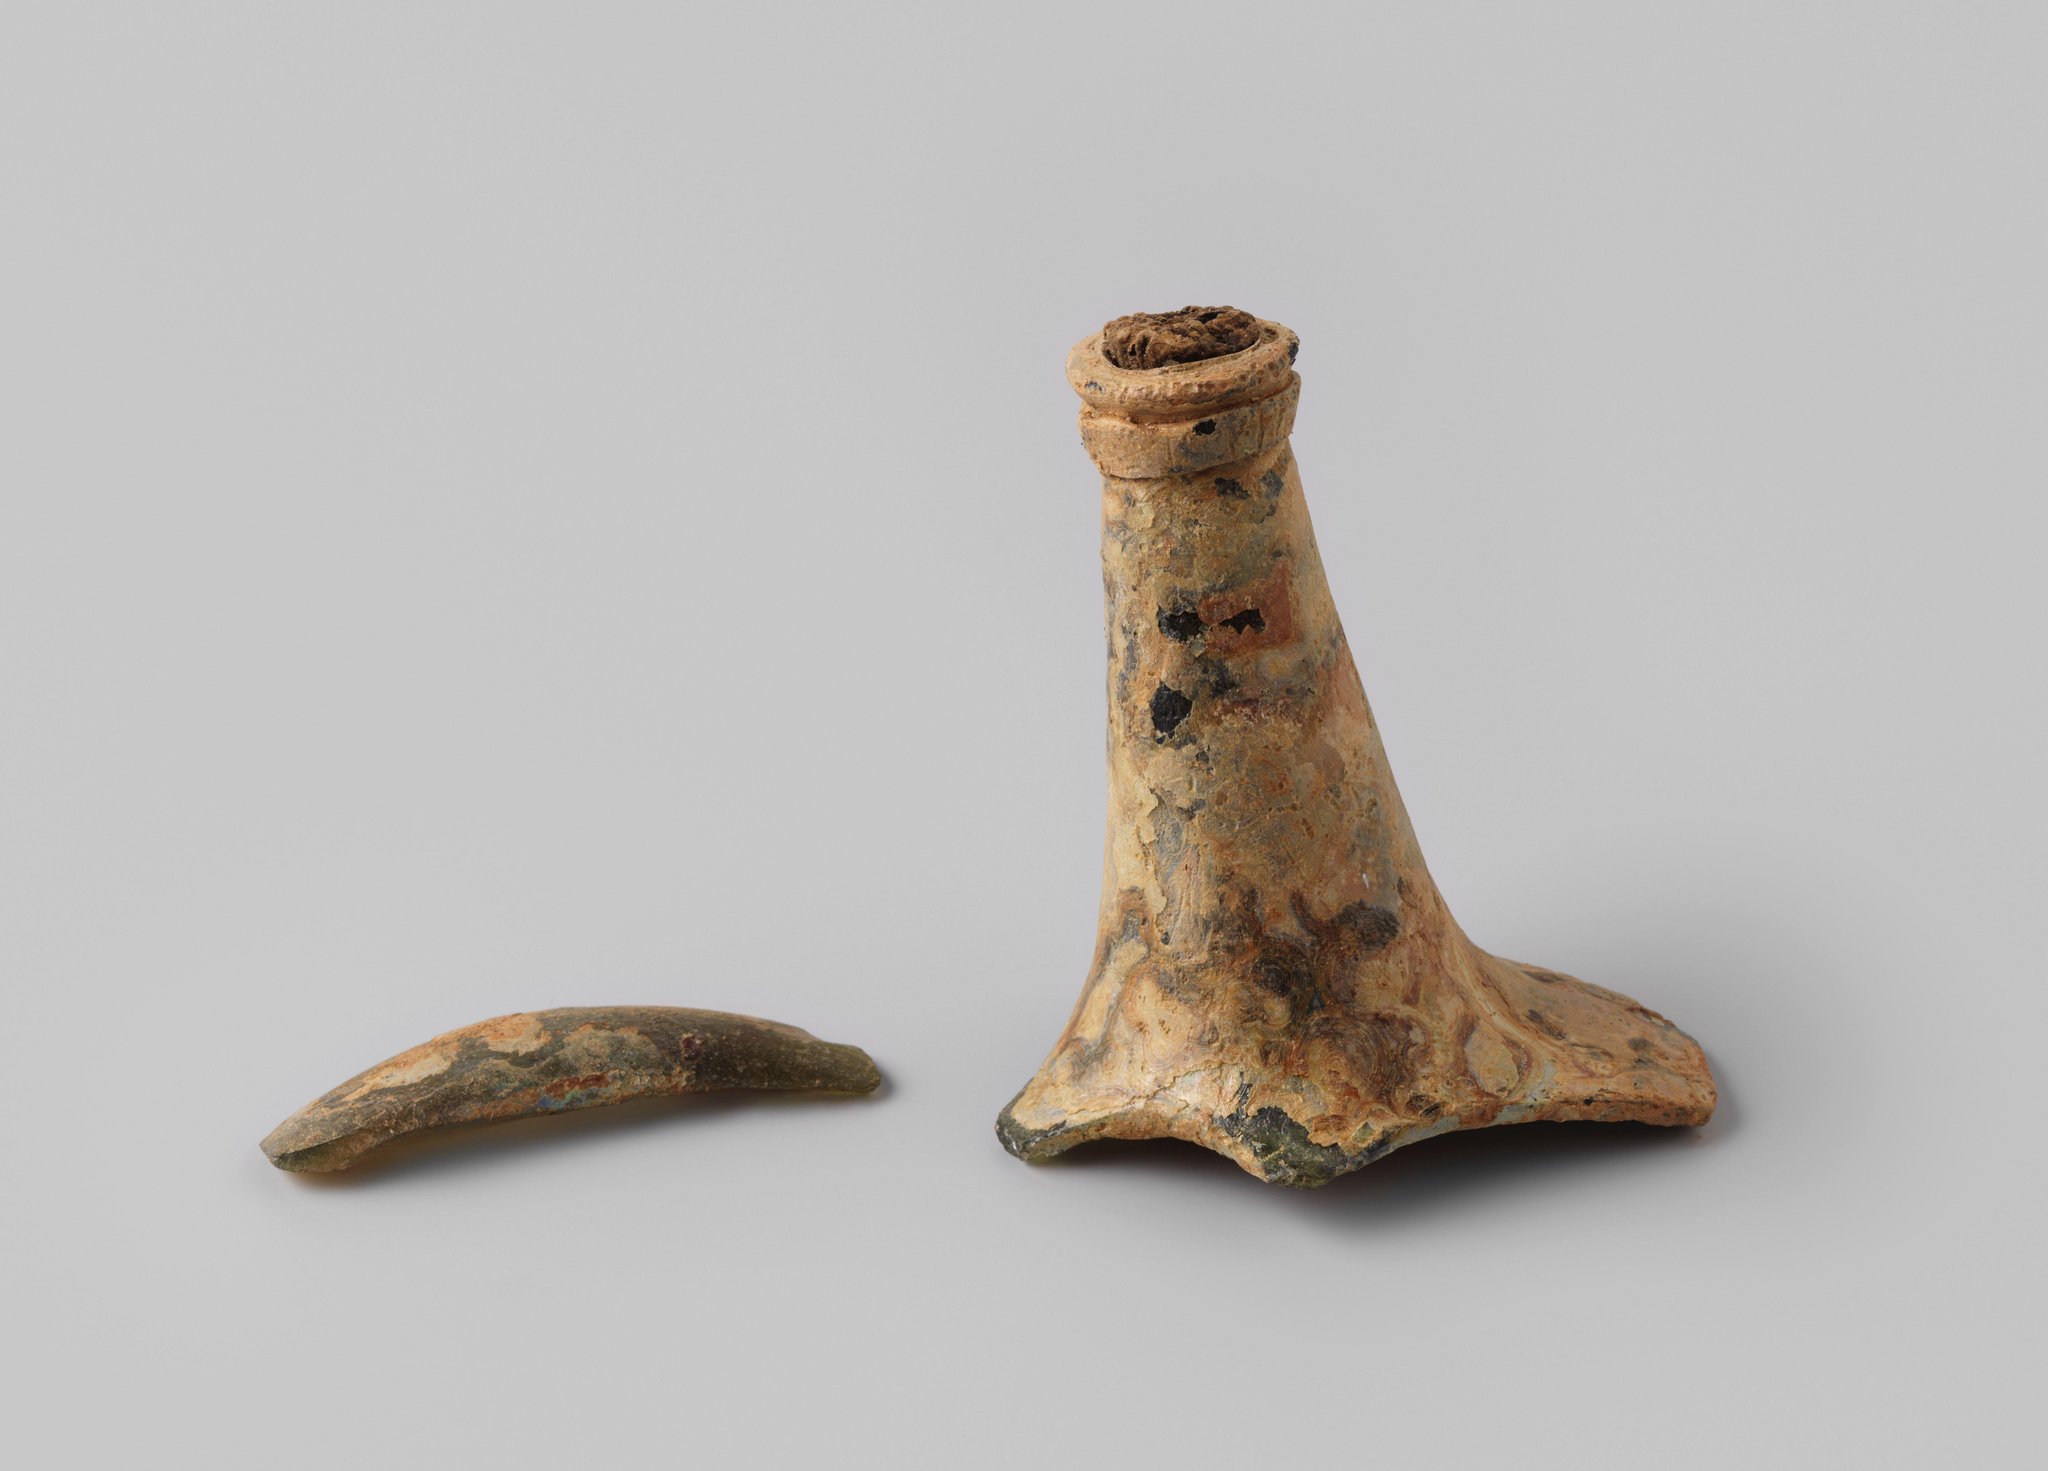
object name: sherd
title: Hals met kurk van een wijnfles en een glasscherf uit het wrak van de Oost-Indiëvaarder Hollandia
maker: Anonymous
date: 1700-1743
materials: glass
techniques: green glass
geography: netherlands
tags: verenigde oostindische compagnie, hollandia (schip), annet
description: Wine bottle, continental production, neck, onion-shaped bottle or bottle with vertical side; f-string rim, projecting cork